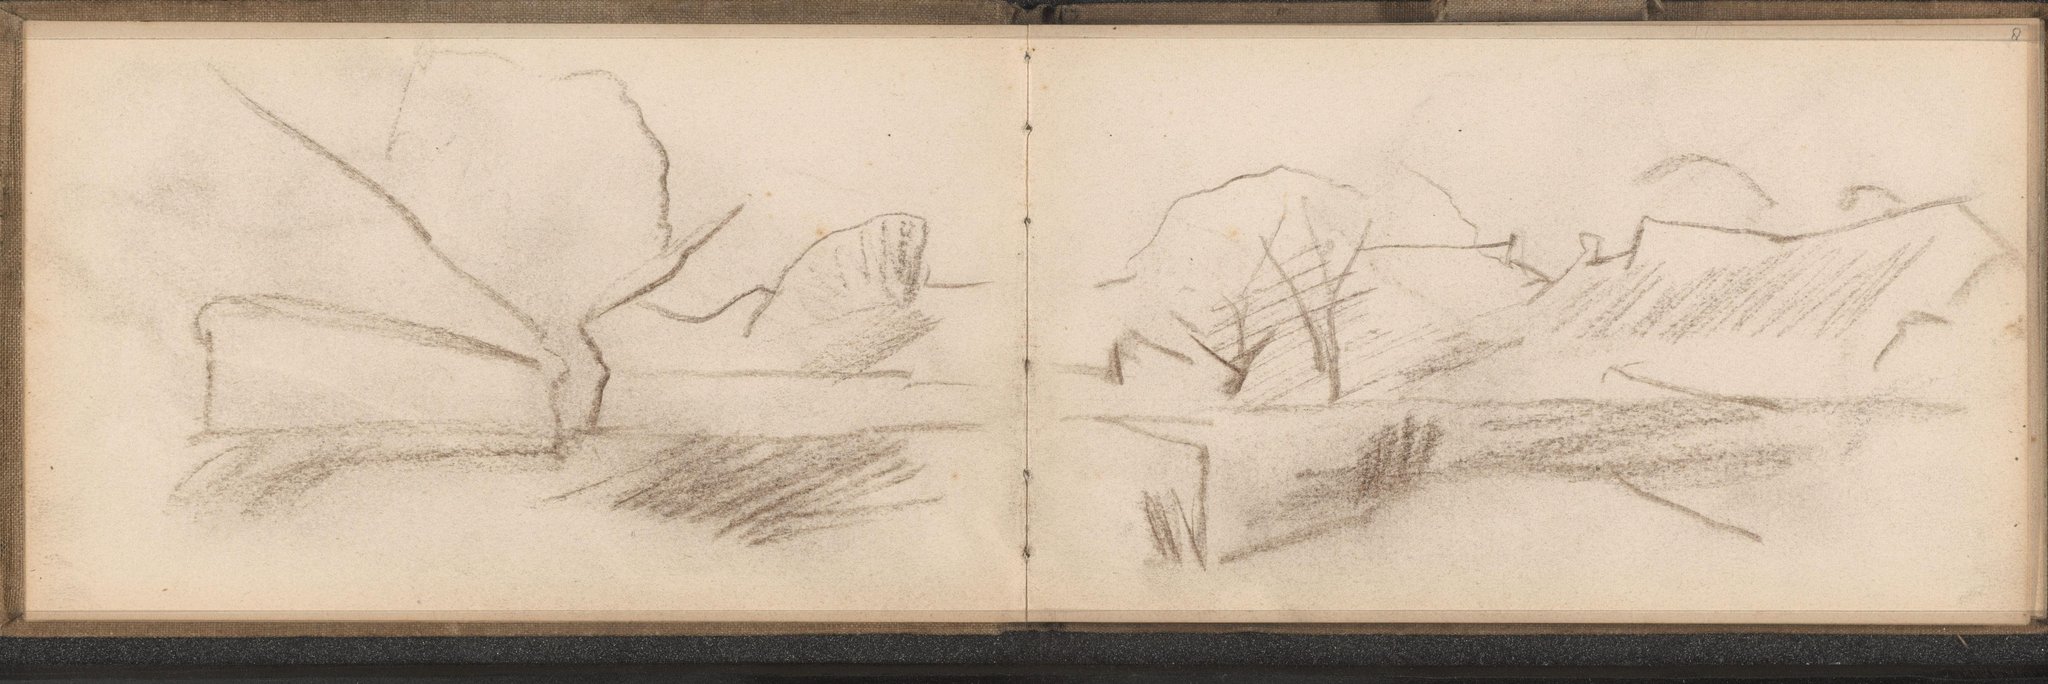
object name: sketchbook leaf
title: Landschap met boerderijen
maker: george hendrik breitner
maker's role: draughtsman, painter, print maker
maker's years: 1857-1923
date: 1883-1885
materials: chalk, paper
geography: drenthe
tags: farm (building)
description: Pagina 7 en pagina 8 uit een schetsboek met 48 bladen.